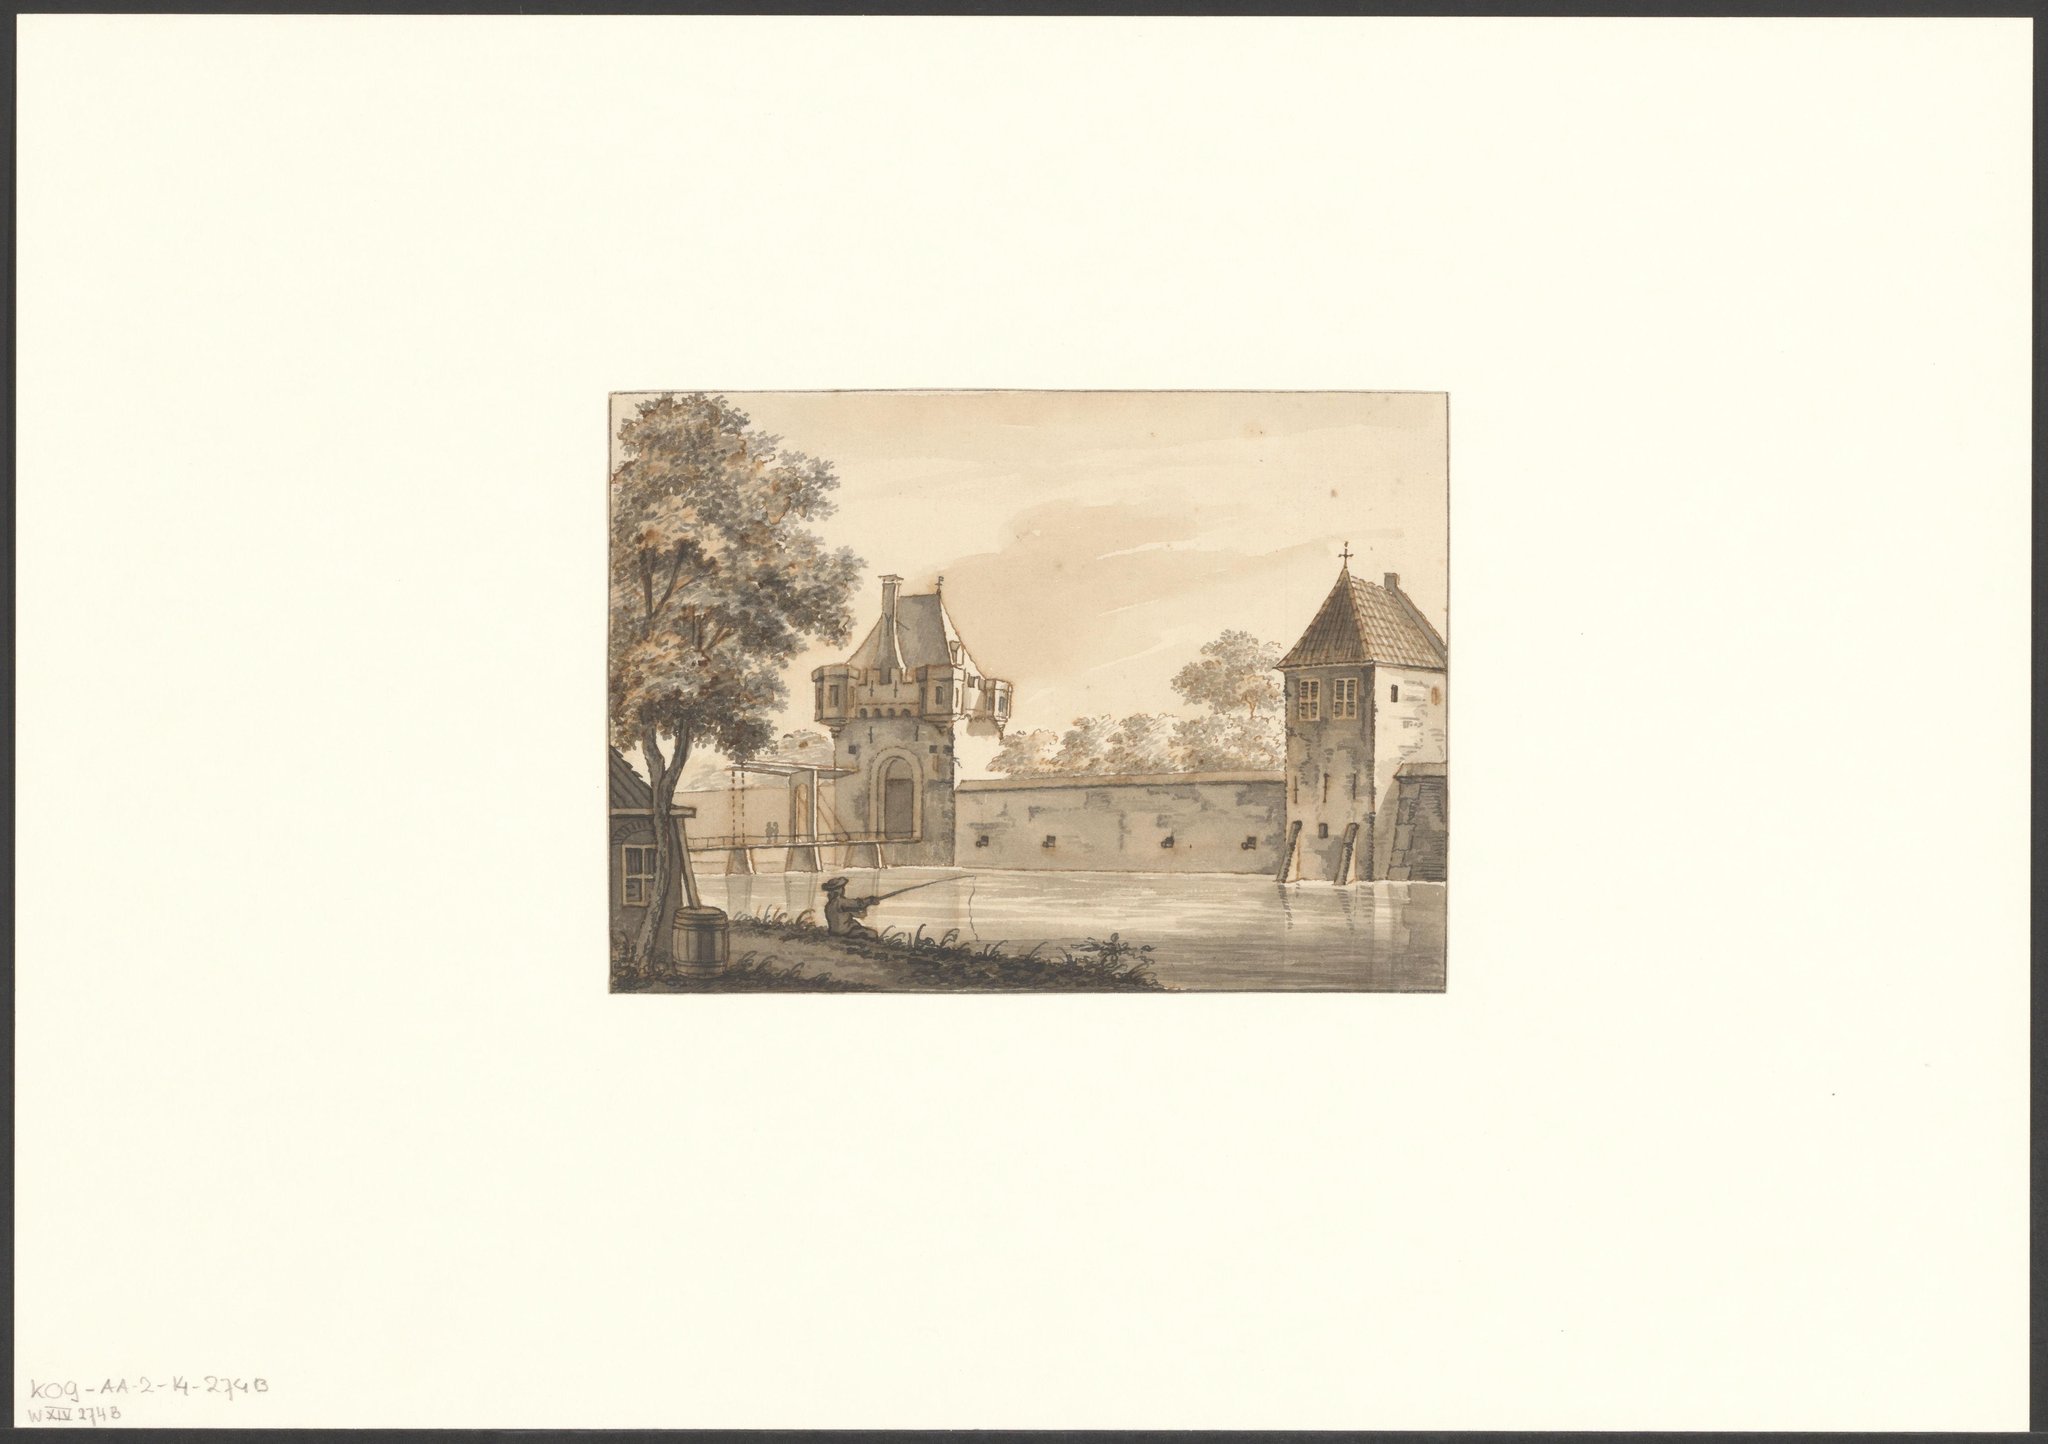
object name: drawing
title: Gezicht op de Heiligewegspoort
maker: Anonymous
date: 1700-1799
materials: ink, paper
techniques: brush, pen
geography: amsterdam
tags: city-view in general; 'veduta', river, city-gate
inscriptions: inscription: ‘Heilige wegs Poort’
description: Tekening binnen de Atlas Van Eck ingedeeld op wijknummer 14.